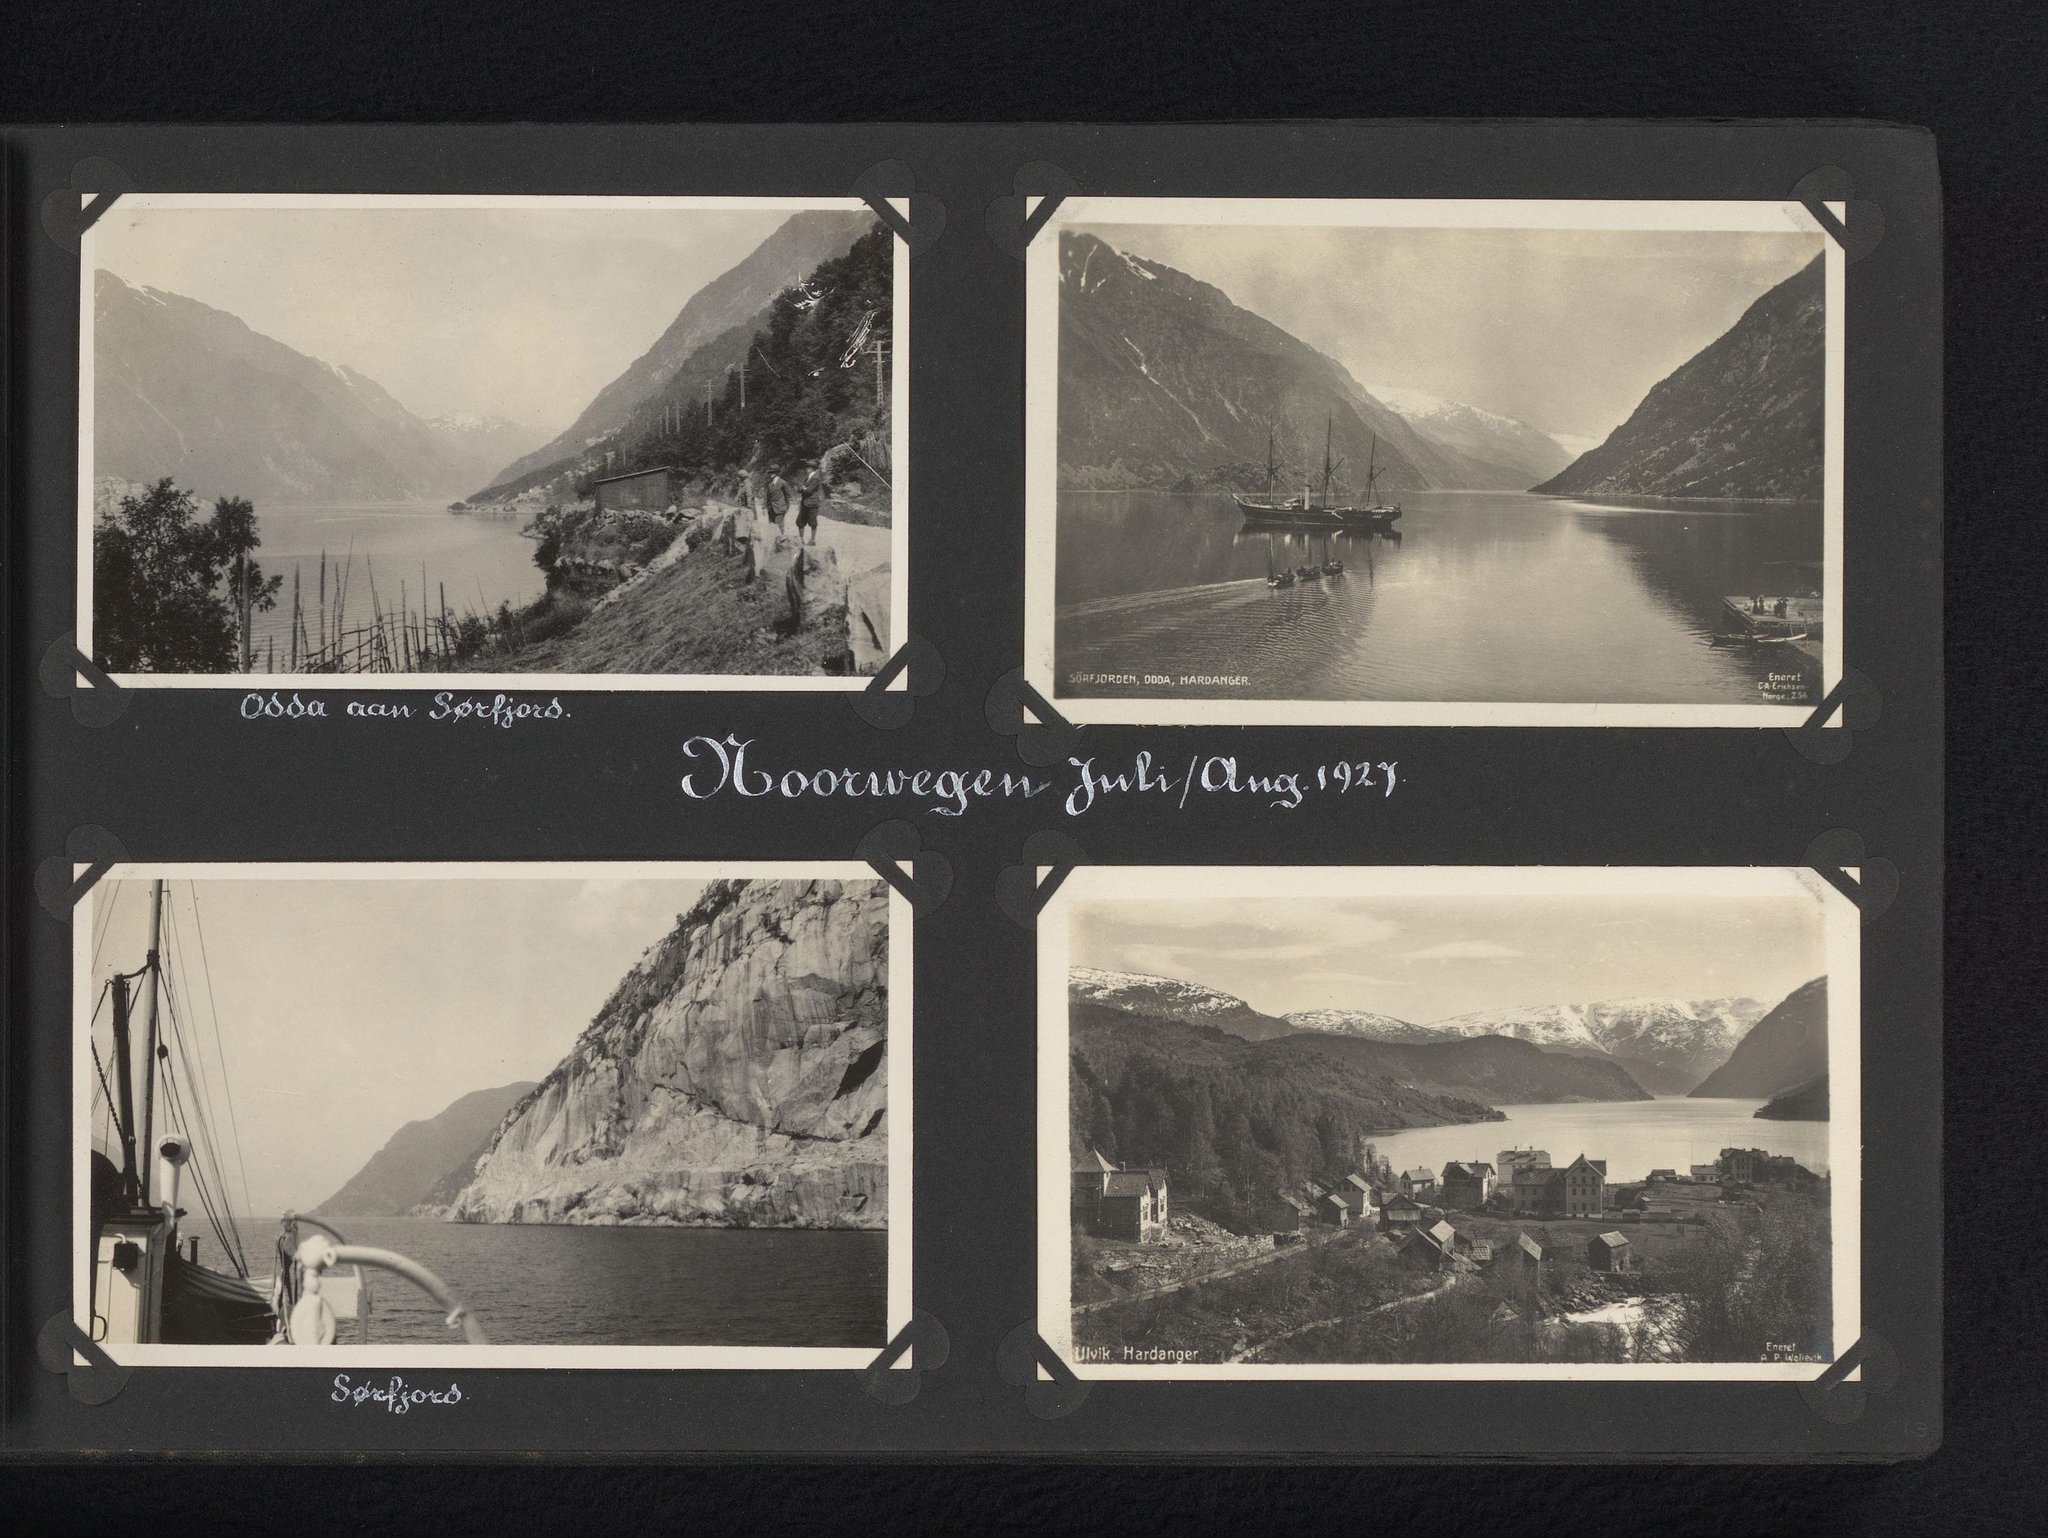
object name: ansichtkaart, prentbriefkaart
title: Noorwegen Juli/Aug. 1927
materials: paper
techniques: gelatin silver print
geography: norway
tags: fjord, sea loch, mountains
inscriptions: inscription: ‘Odda aan Sørfjord’, inscription: ‘Sørfjord’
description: Deze foto's maken deel uit van een album.